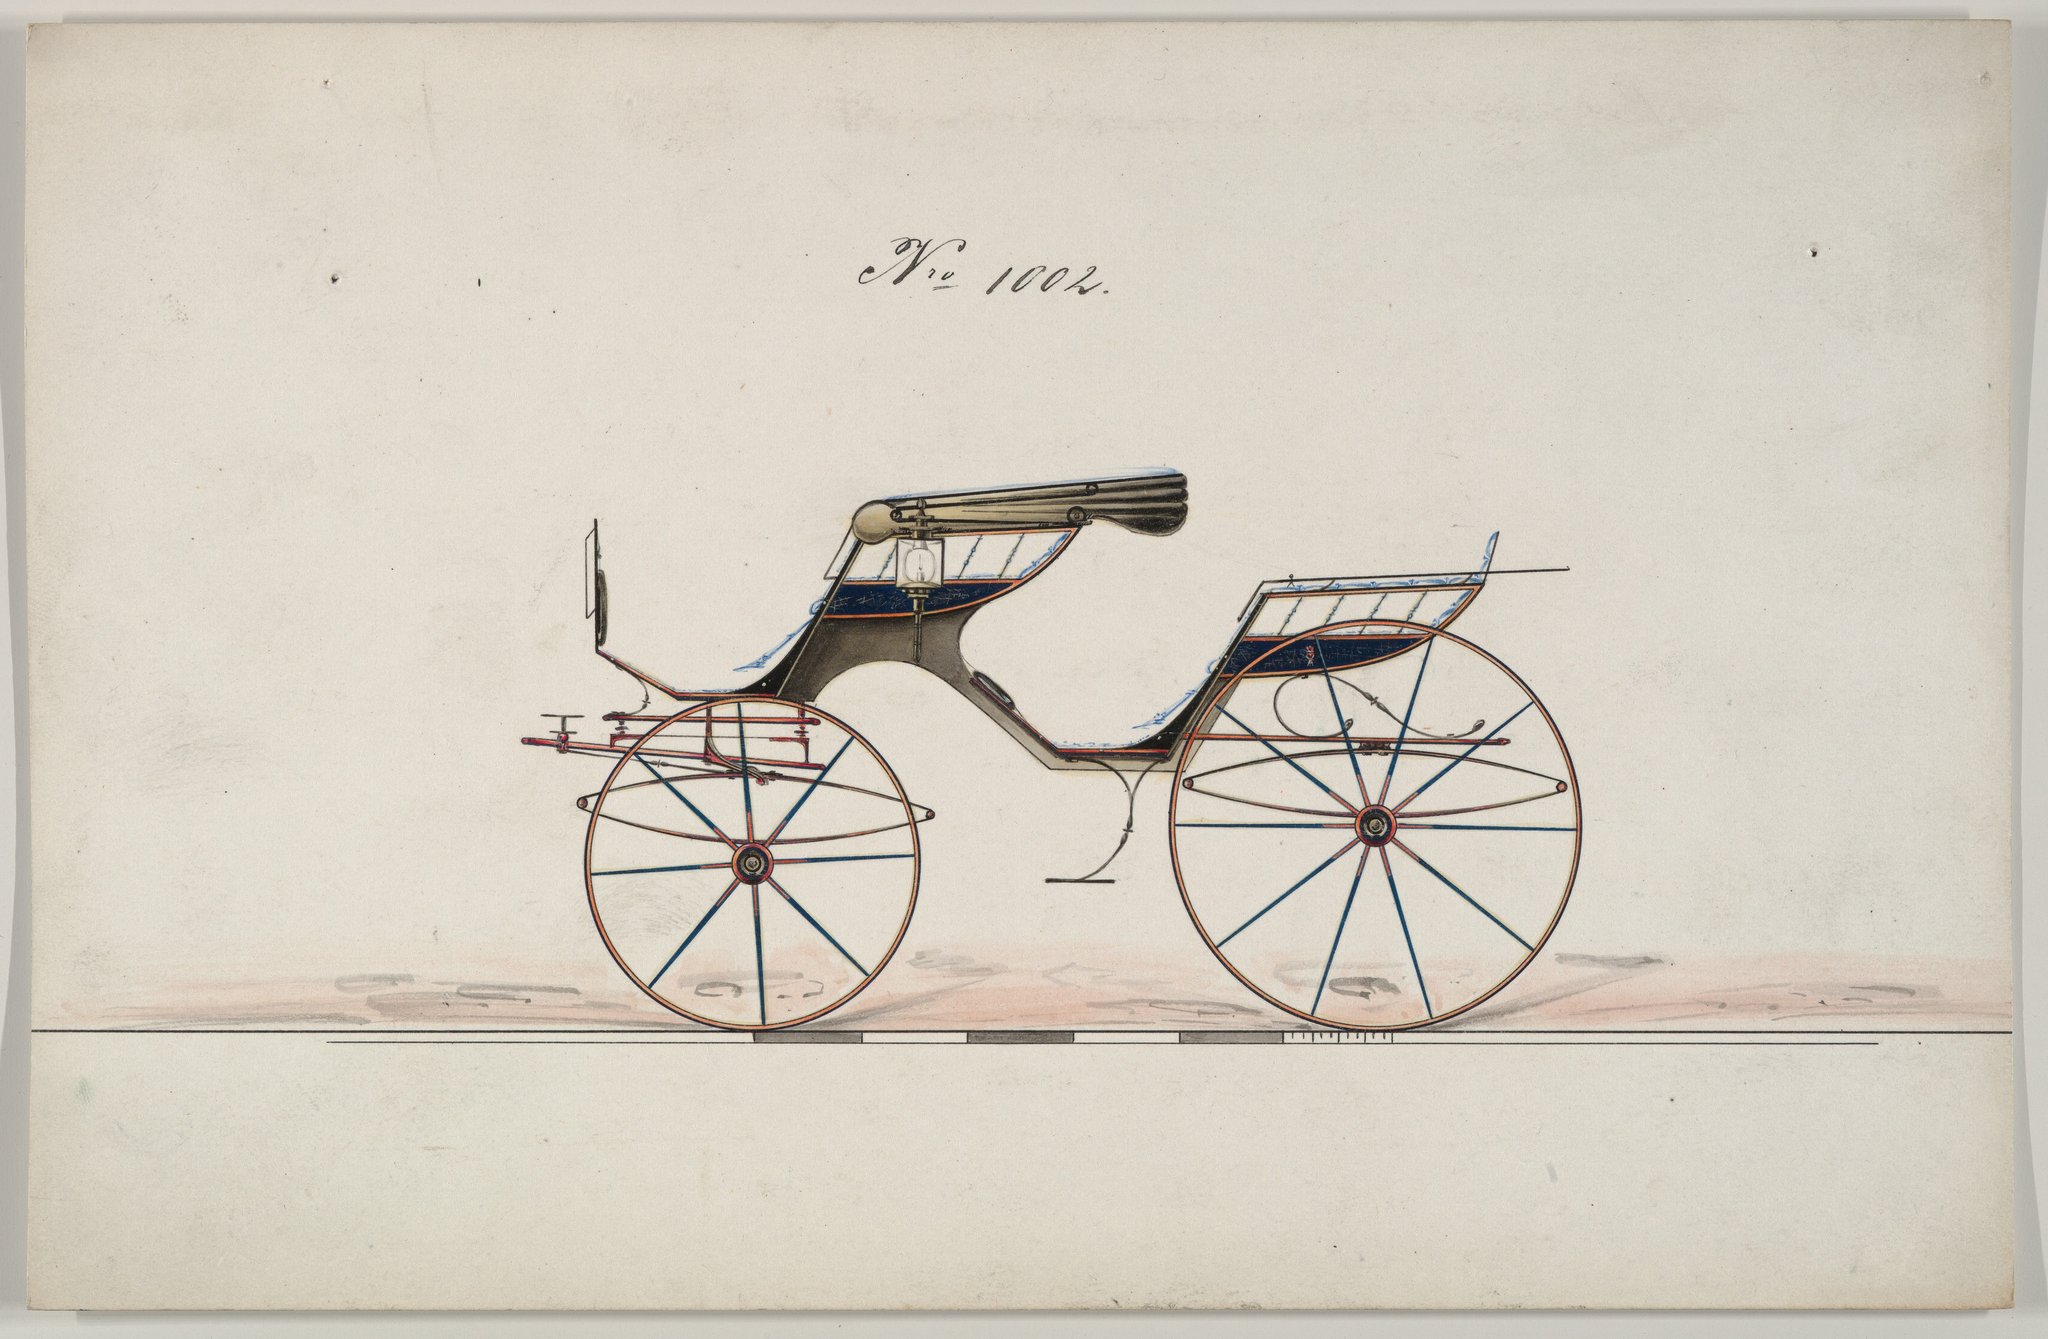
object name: drawing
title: Design for Phaeton, no. 1002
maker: brewster & co.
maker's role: manufacturer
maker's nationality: american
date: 1850-1874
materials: gouache, ink, watercolor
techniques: pen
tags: carriages